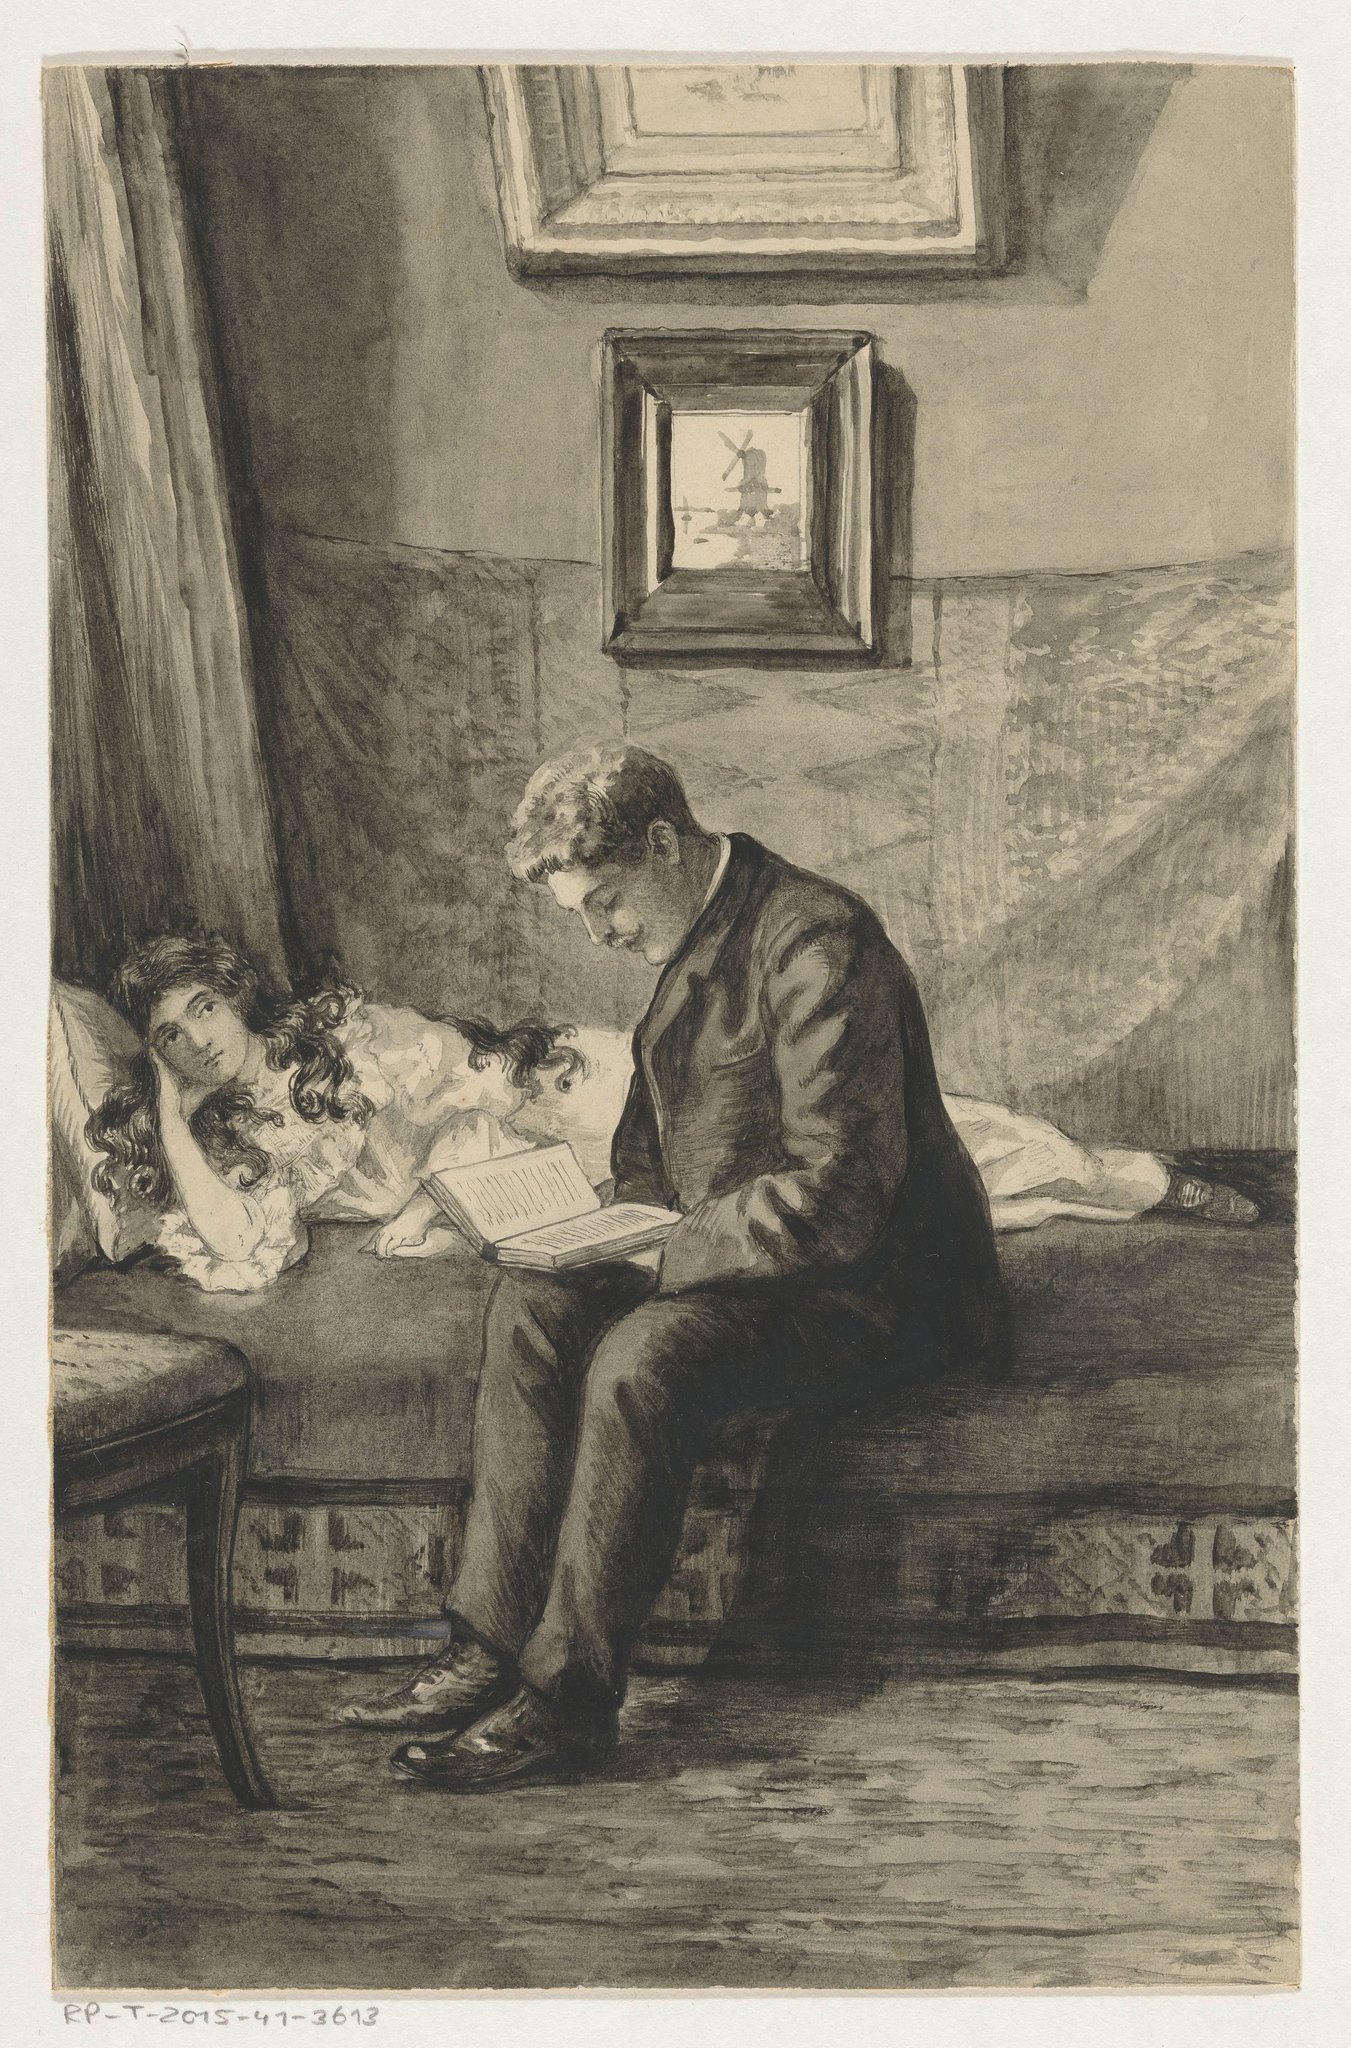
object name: drawing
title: Jongeman leest meisje voor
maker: anna maria kruijff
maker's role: draughtsman, print maker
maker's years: 1870-1946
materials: paper, pencil, watercolor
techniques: brush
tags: reading to somebody, lying figure - aa - female human figure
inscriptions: collector's mark: Lugt 2228a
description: Een meisje ligt op een bank. Naast haar zit een man die voorleest uit een boek.